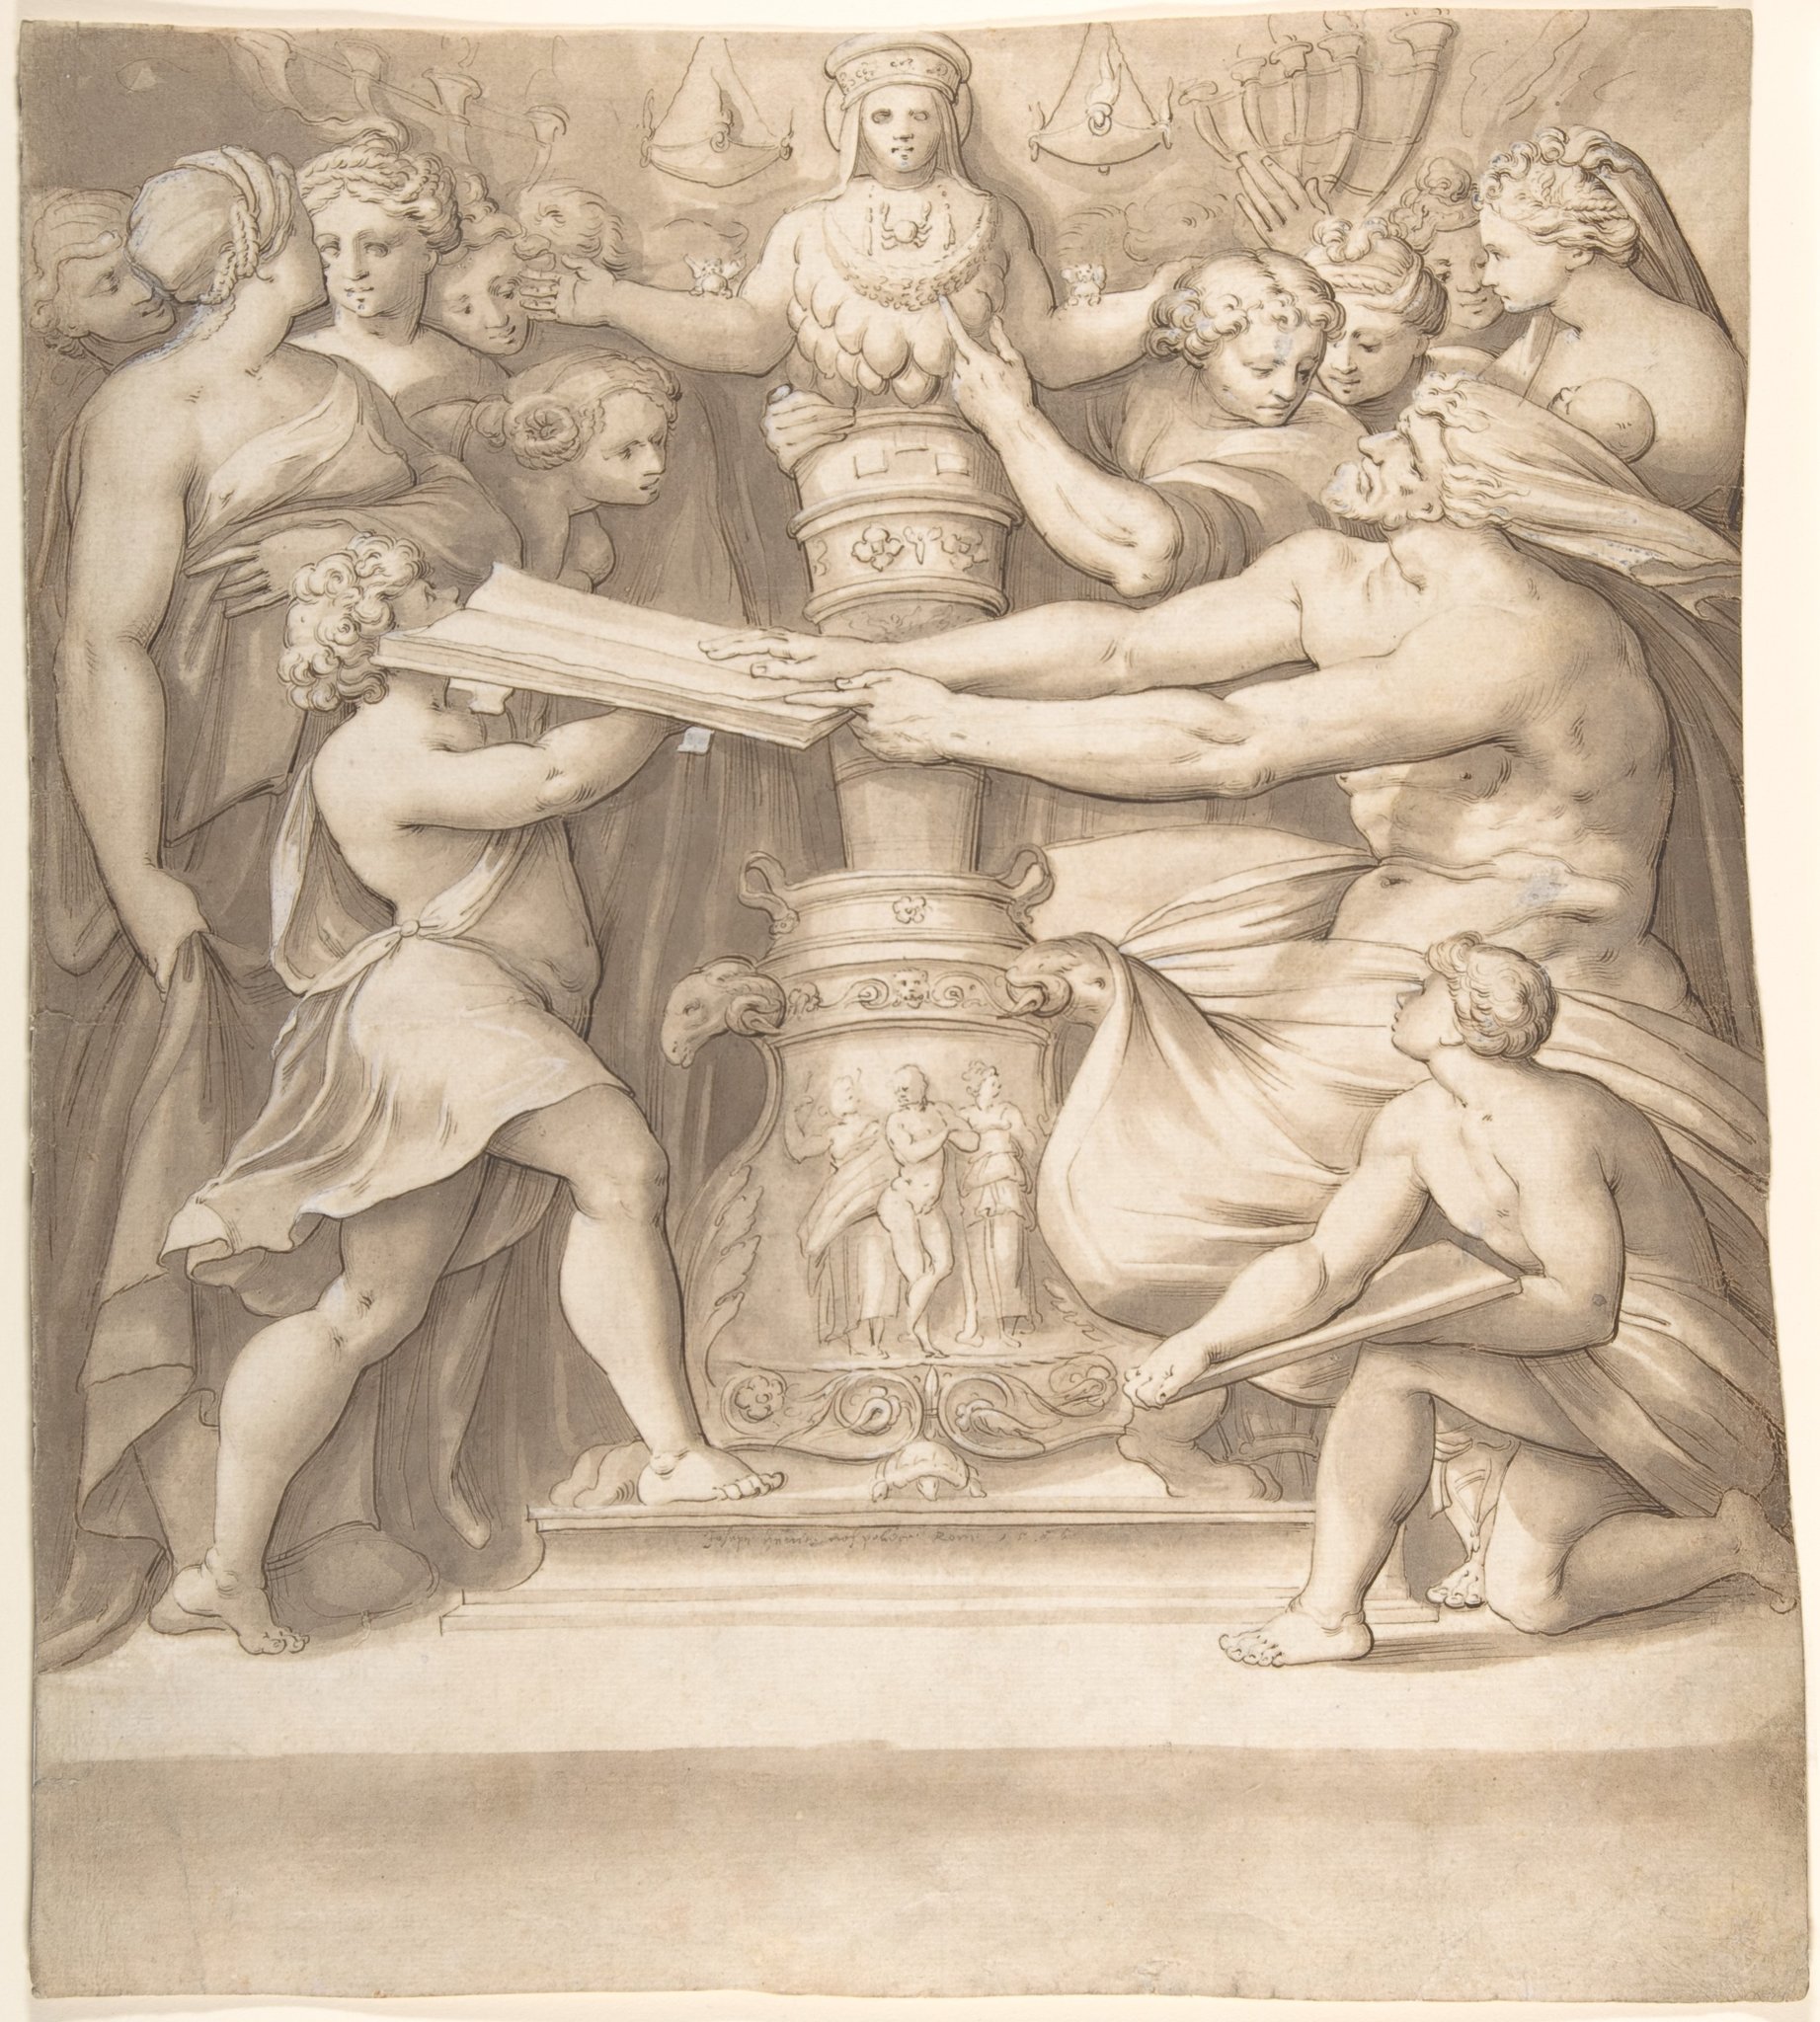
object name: drawing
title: Figures Adoring a Statue of the "Magna Mater"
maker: joseph heintz the elder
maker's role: artist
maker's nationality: swiss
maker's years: 1564-1609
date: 1585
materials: ink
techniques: brush, heightening, pen, wash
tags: men,women,goddess